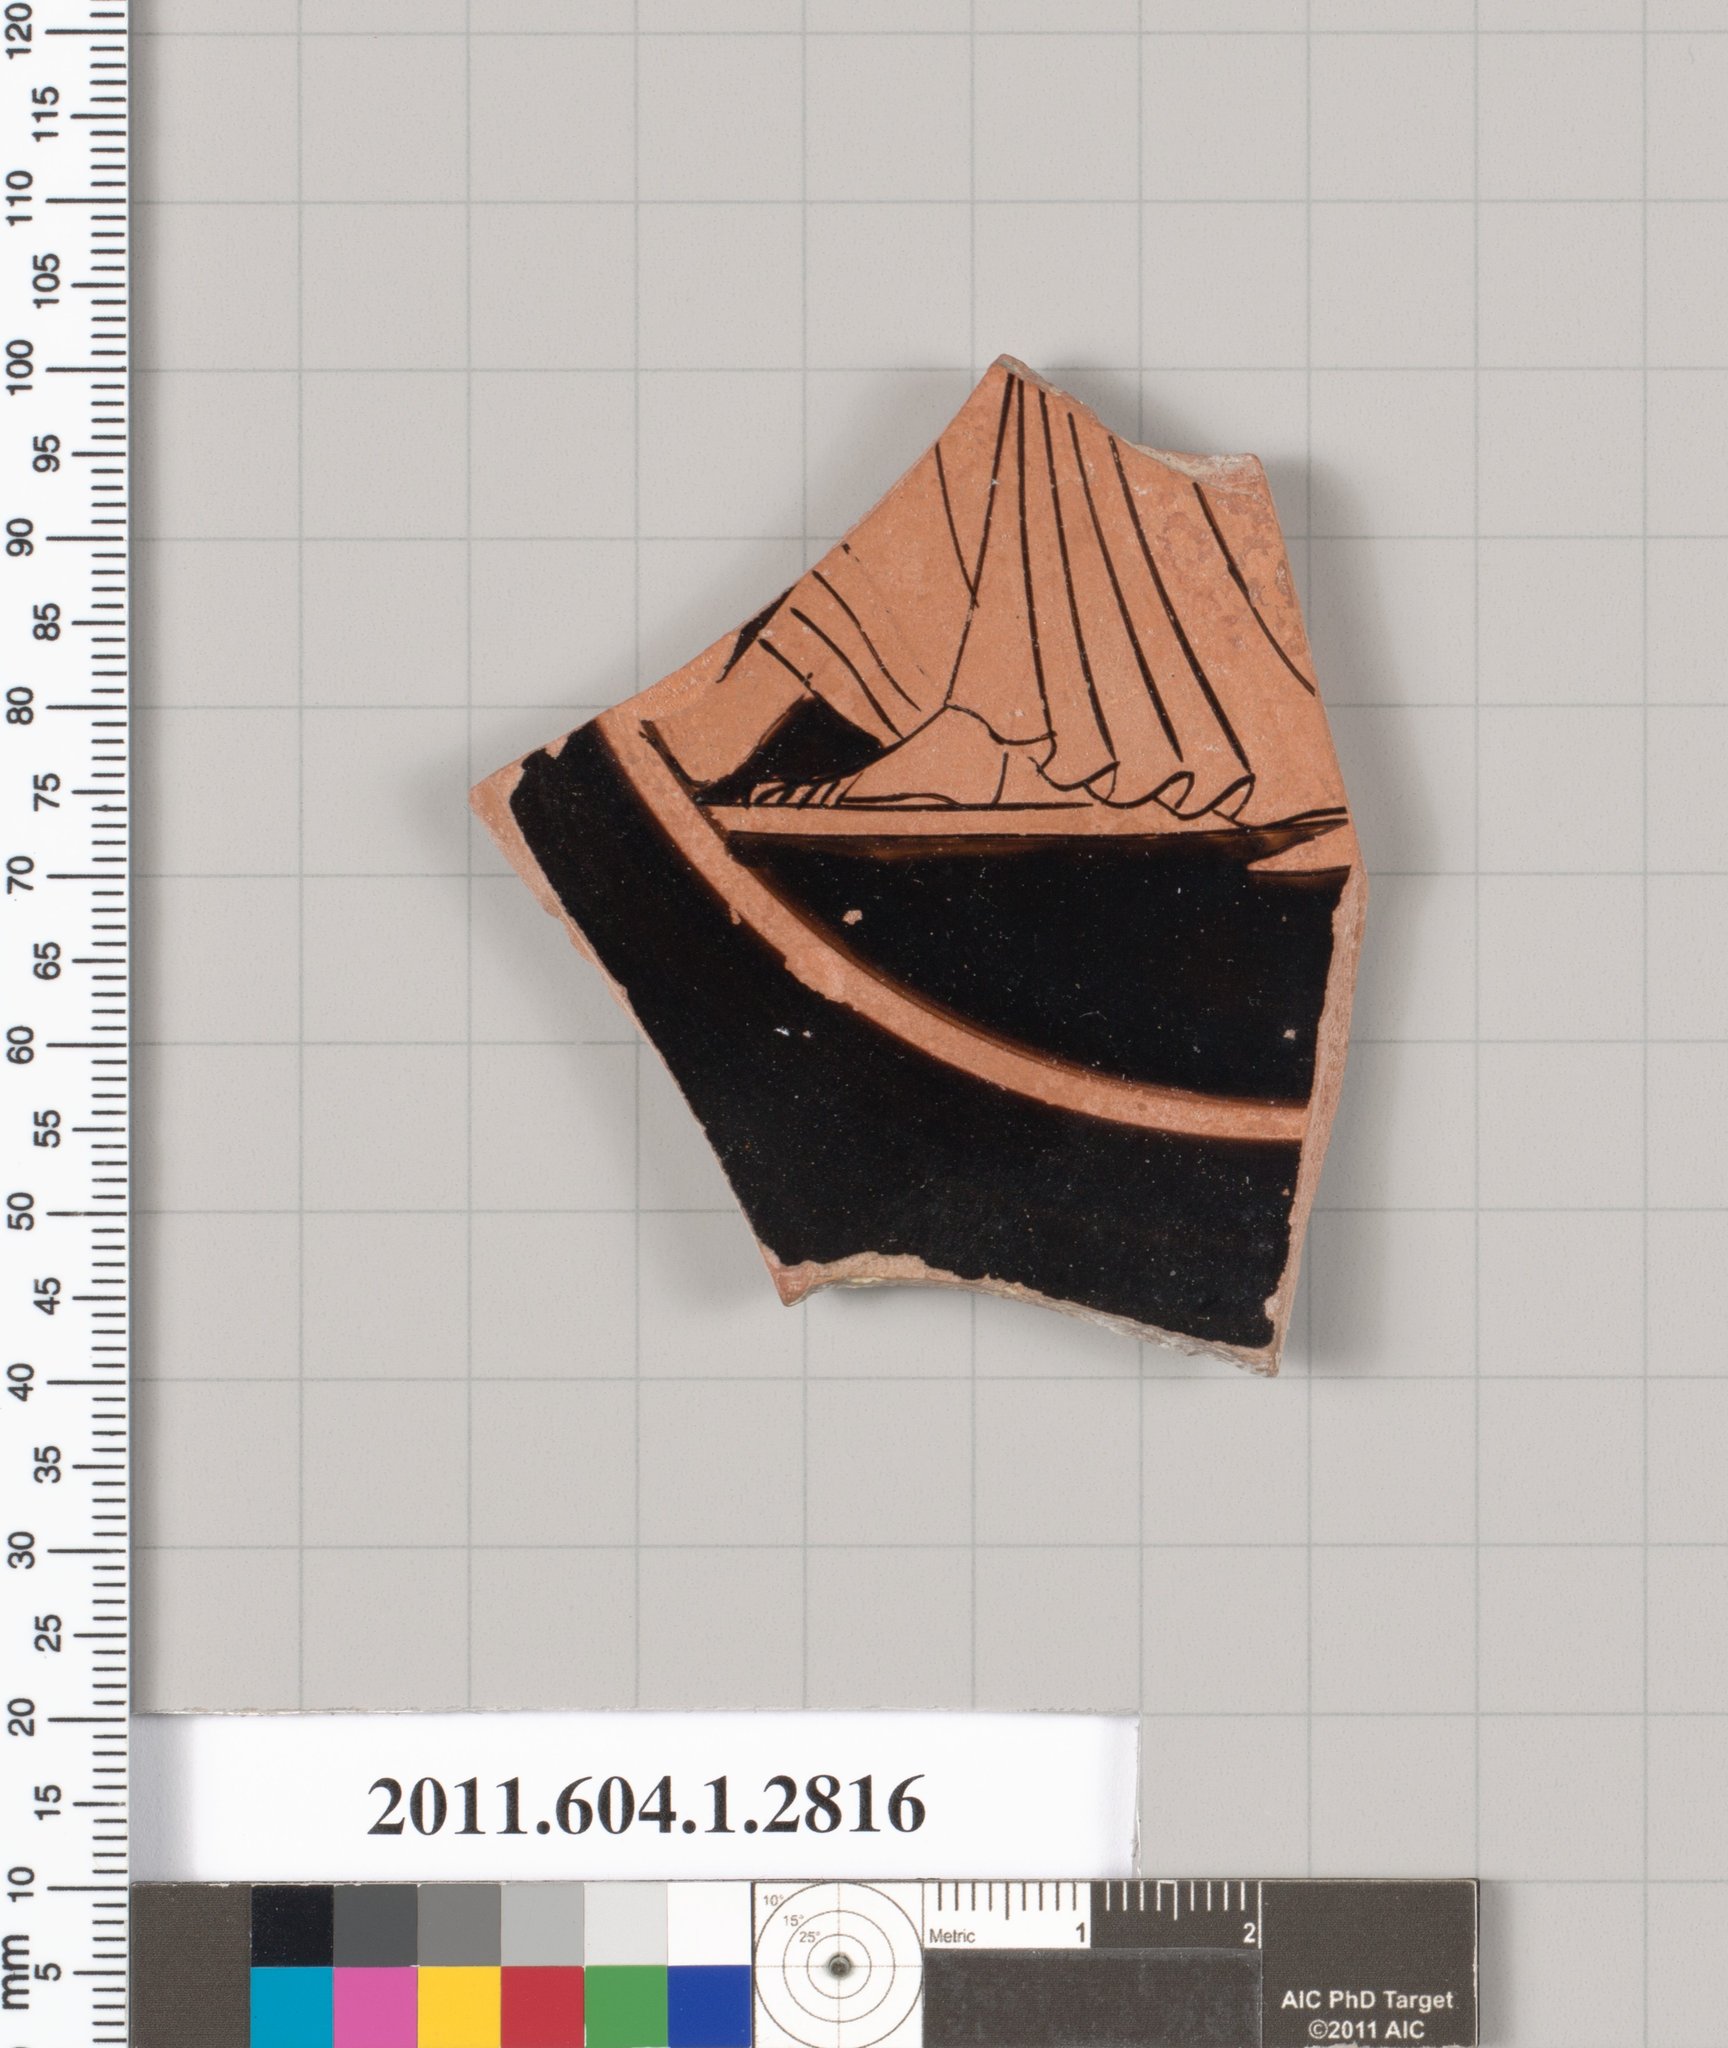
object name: kylix fragment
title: Terracotta fragment of a kylix (drinking cup)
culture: greek, attic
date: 510-490 BCE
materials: terracotta